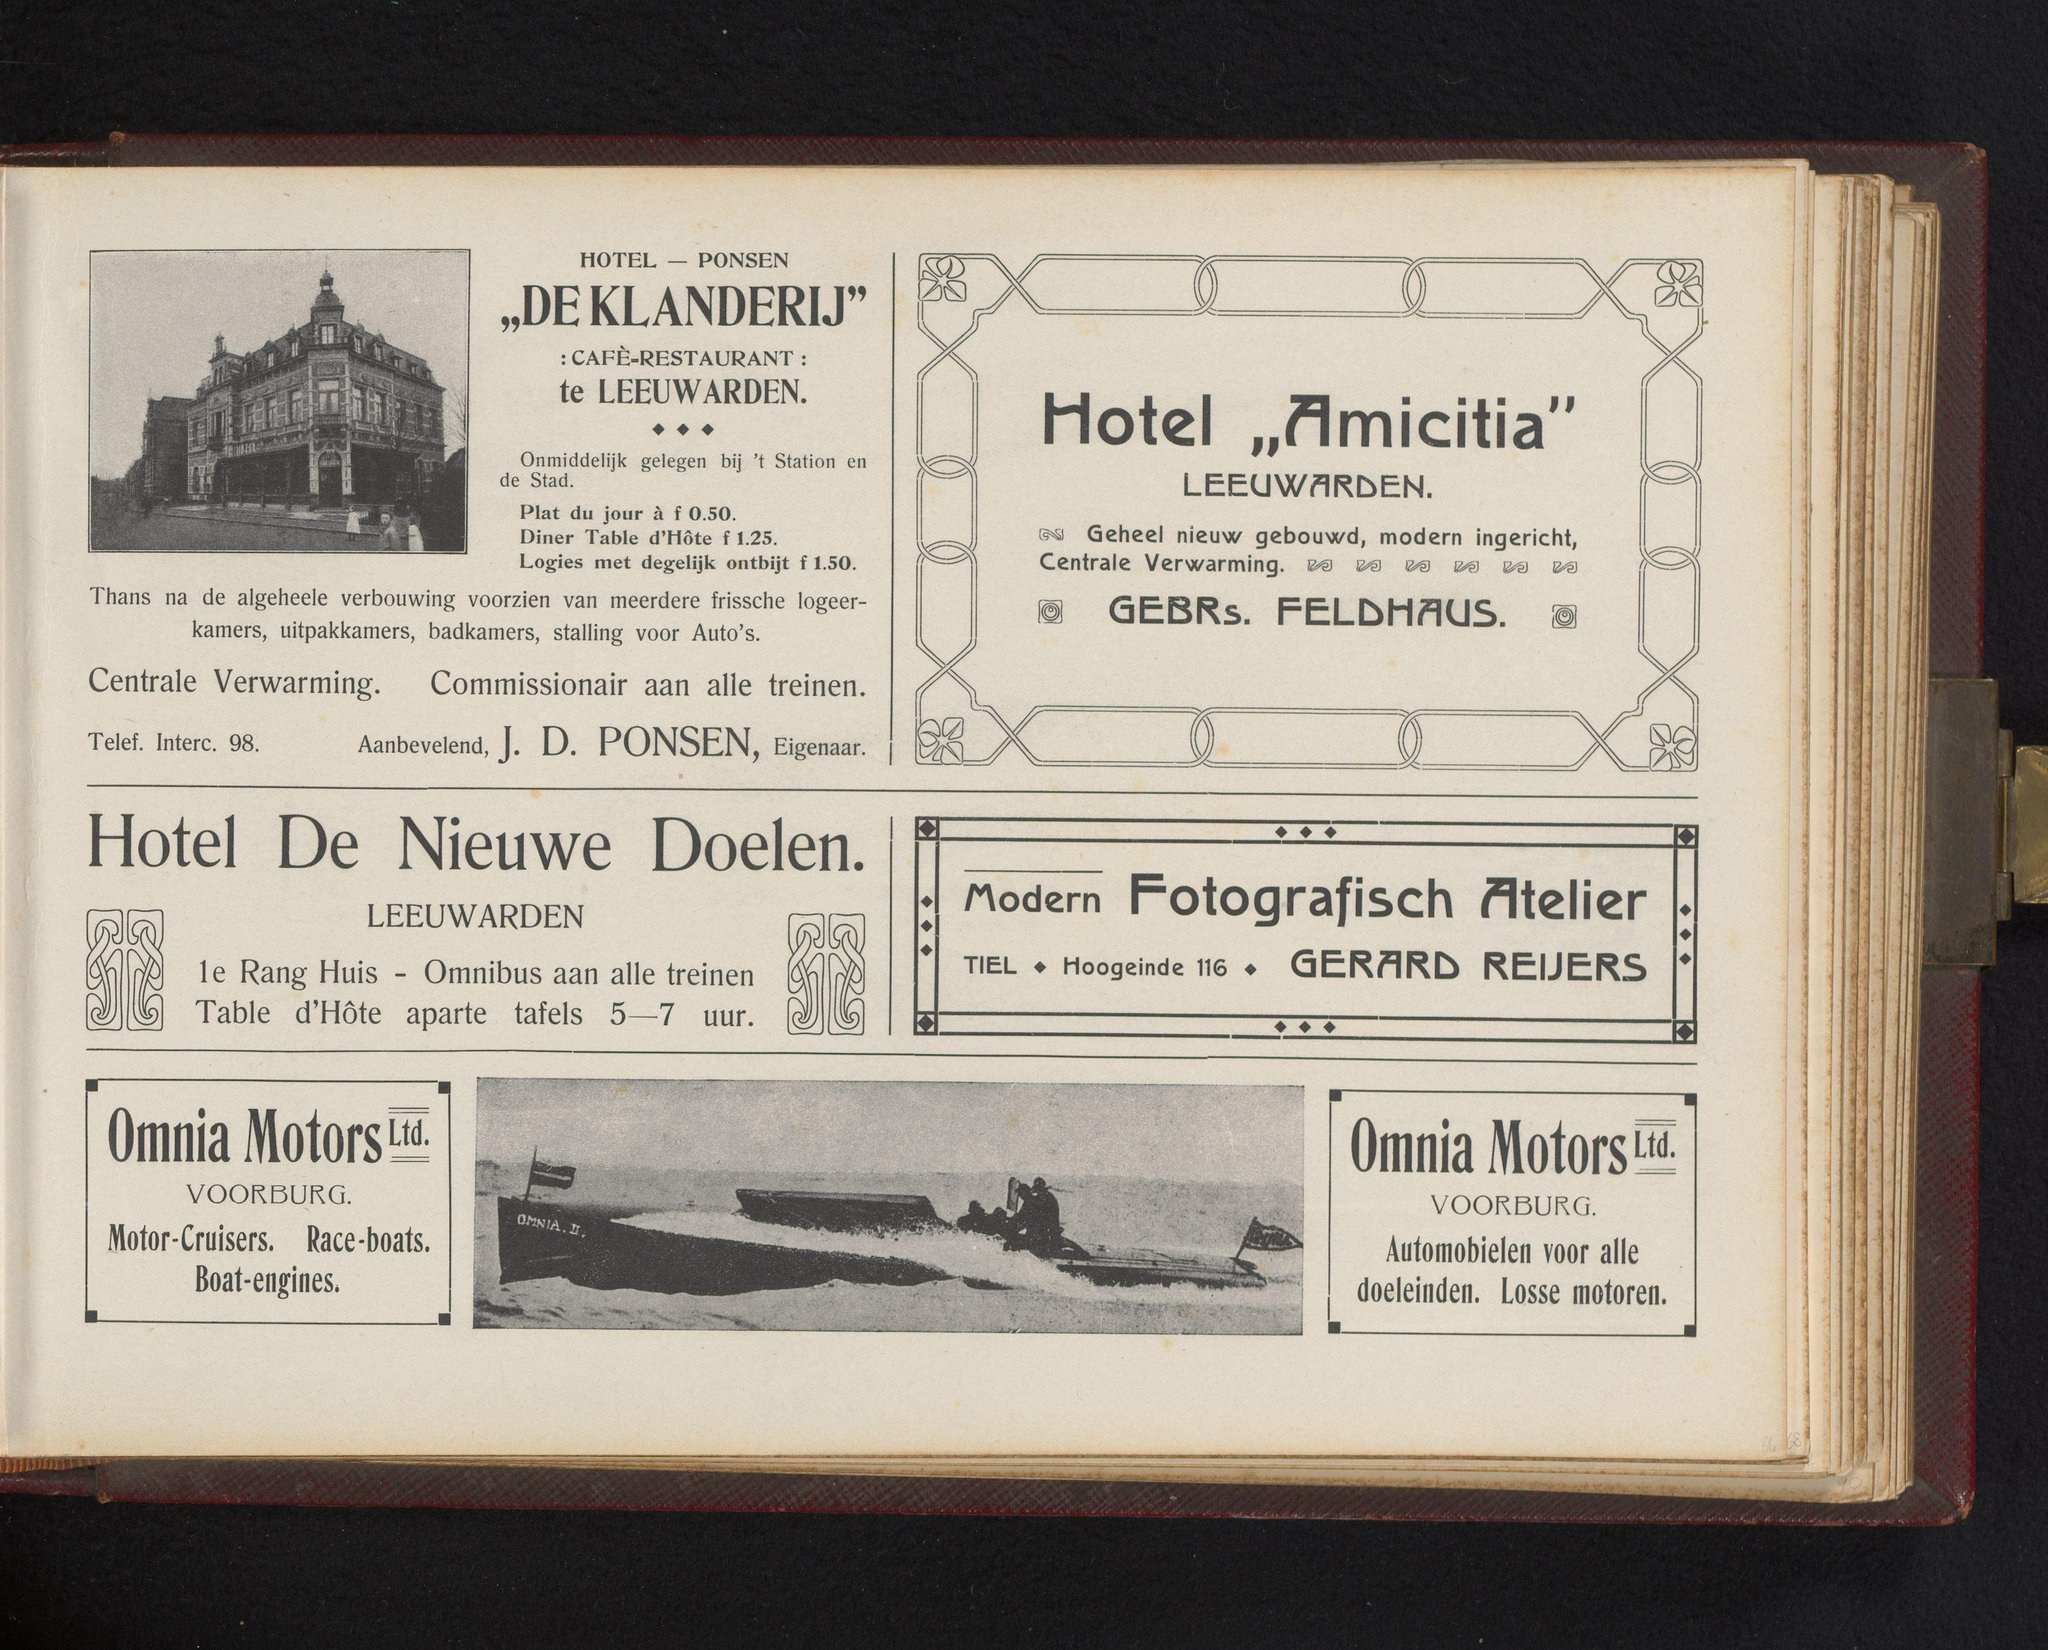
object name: photomechanical print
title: Advertenties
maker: Anonymous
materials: paper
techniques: printing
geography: netherlands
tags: advertising, ships (in general), hotel, hostelry, inn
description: Advertenties voor onder andere Horel-Ponsen de Klanderij, Hotel Amicitia, Hotel de Nieuwe Doelen, Modern Fotografisch Atelier Gerard Reijers en Omnia Motors Ltd. Bij enkele advertenties is een autotypie gedrukt. Deze pagina maakt deel uit van een album.